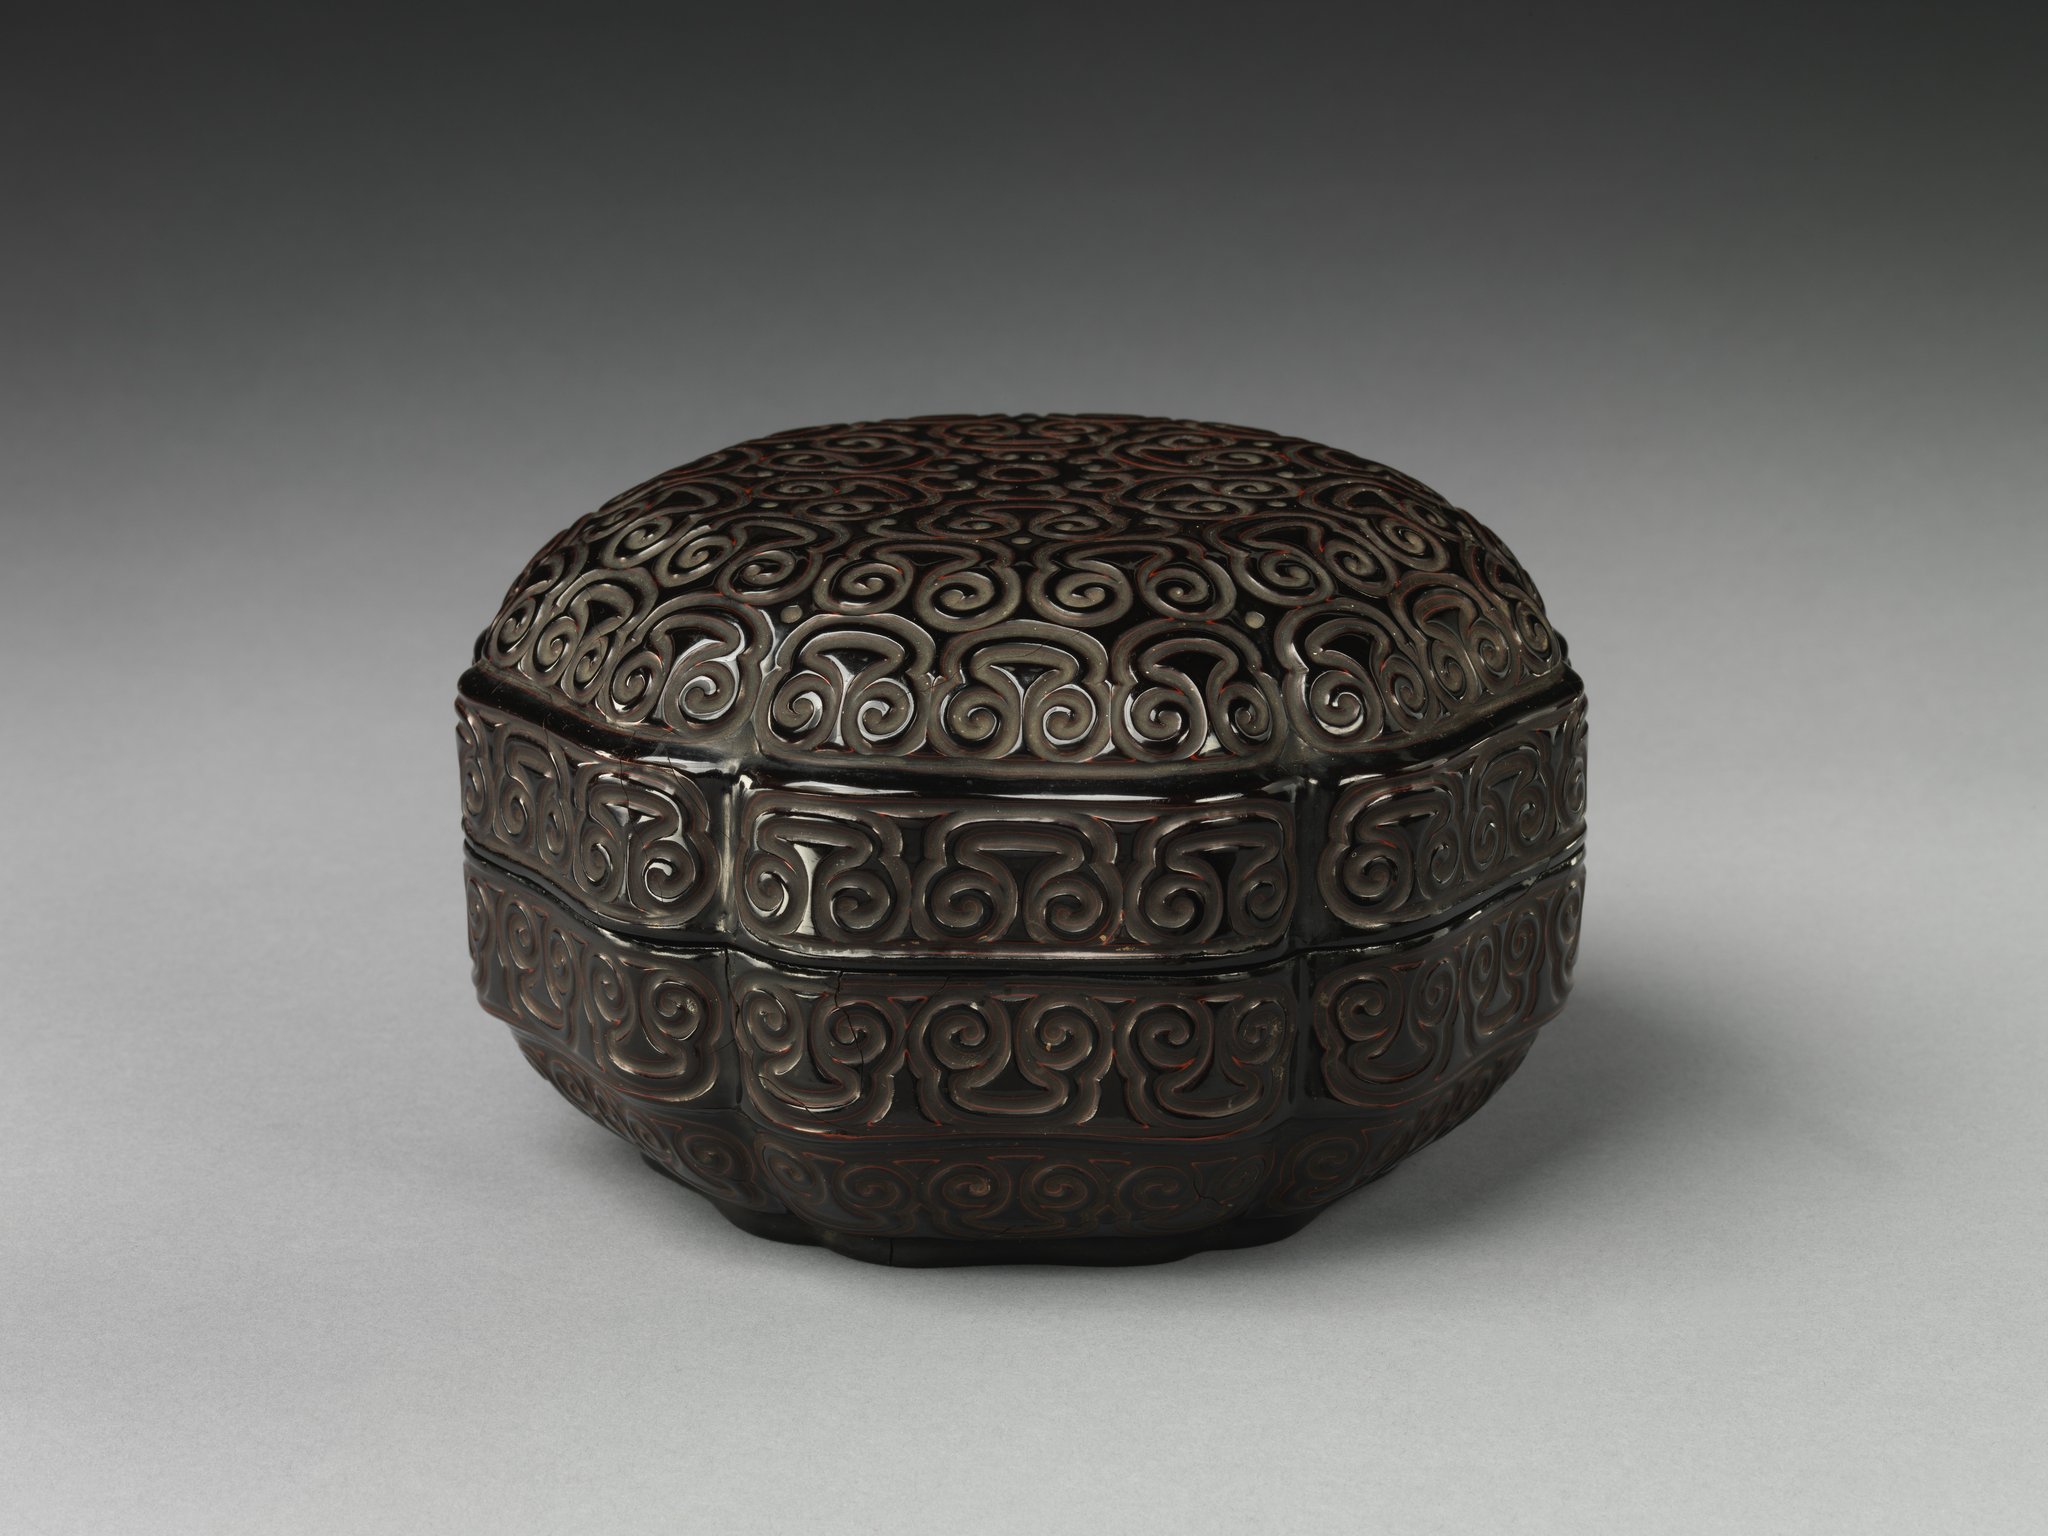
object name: hexagonal box with inverted corner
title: Hexagonal box with inverted corners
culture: chinese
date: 1301-1500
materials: lacquer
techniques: carving